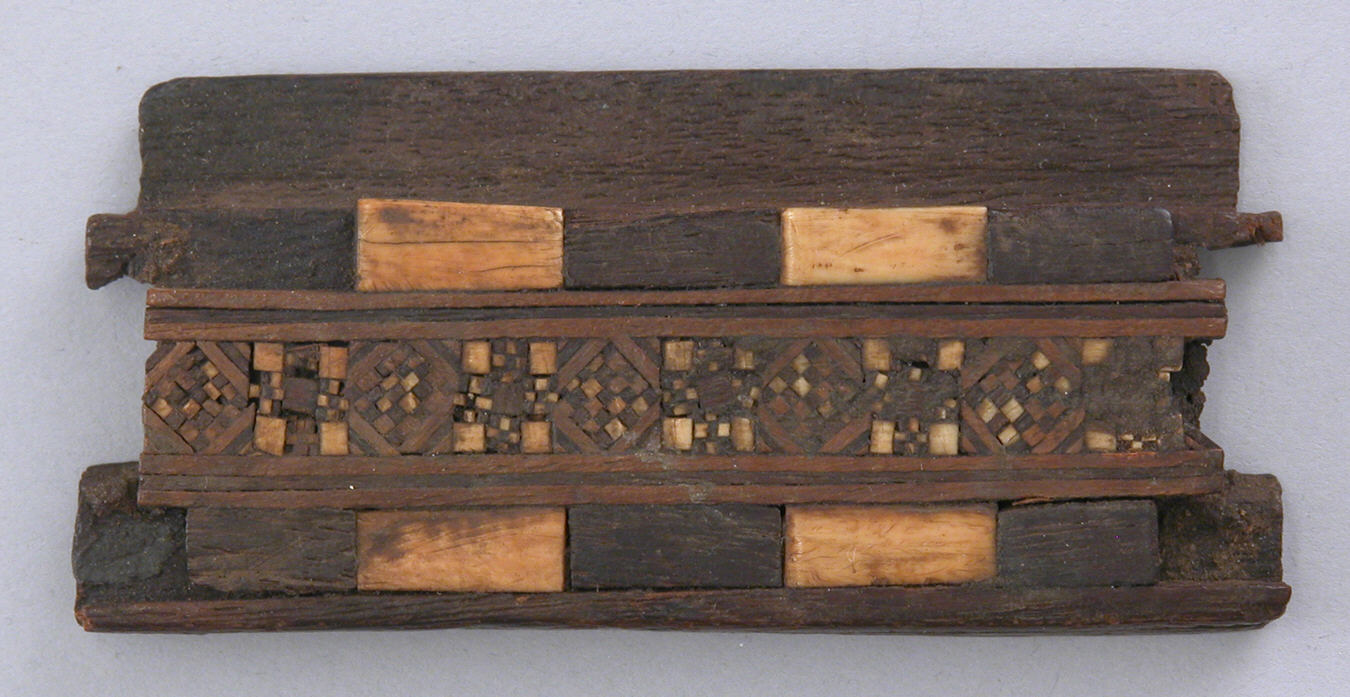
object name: wood fragment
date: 701-900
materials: ivory, wood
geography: egypt